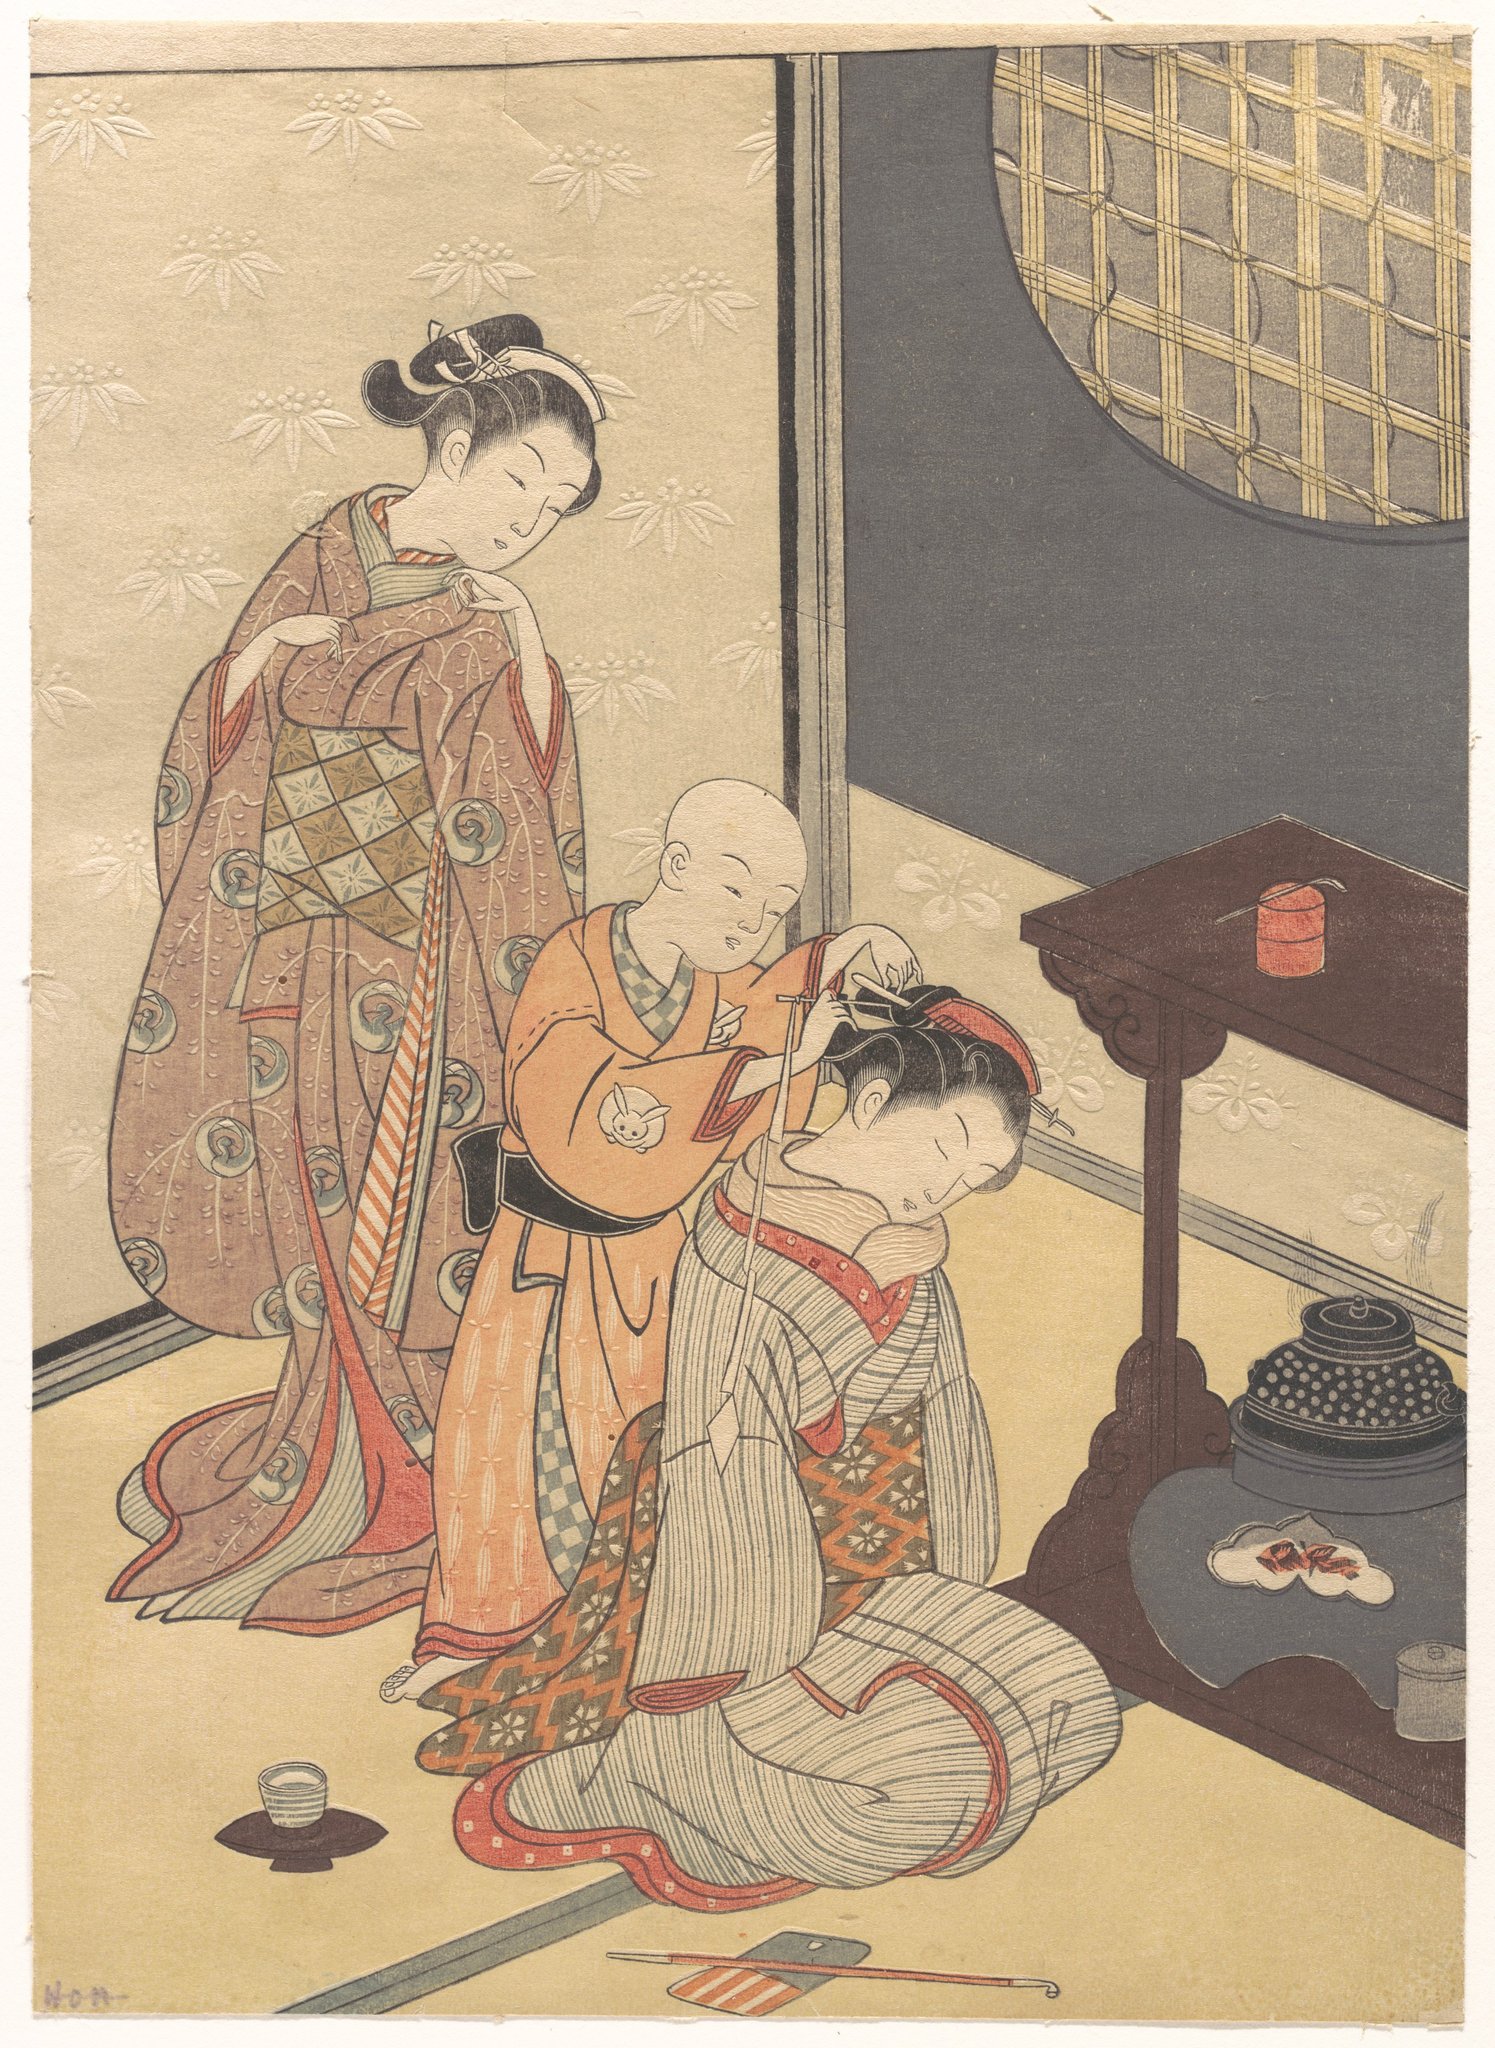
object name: print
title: Night Rain at the Double-Shelf Stand, from the series Eight Parlor Views (Zashiki hakkei)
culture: japanese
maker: suzuki harunobu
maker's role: artist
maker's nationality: japanese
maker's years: 1725-1770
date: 1767-1800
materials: ink, paper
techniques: woodblock print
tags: women,working